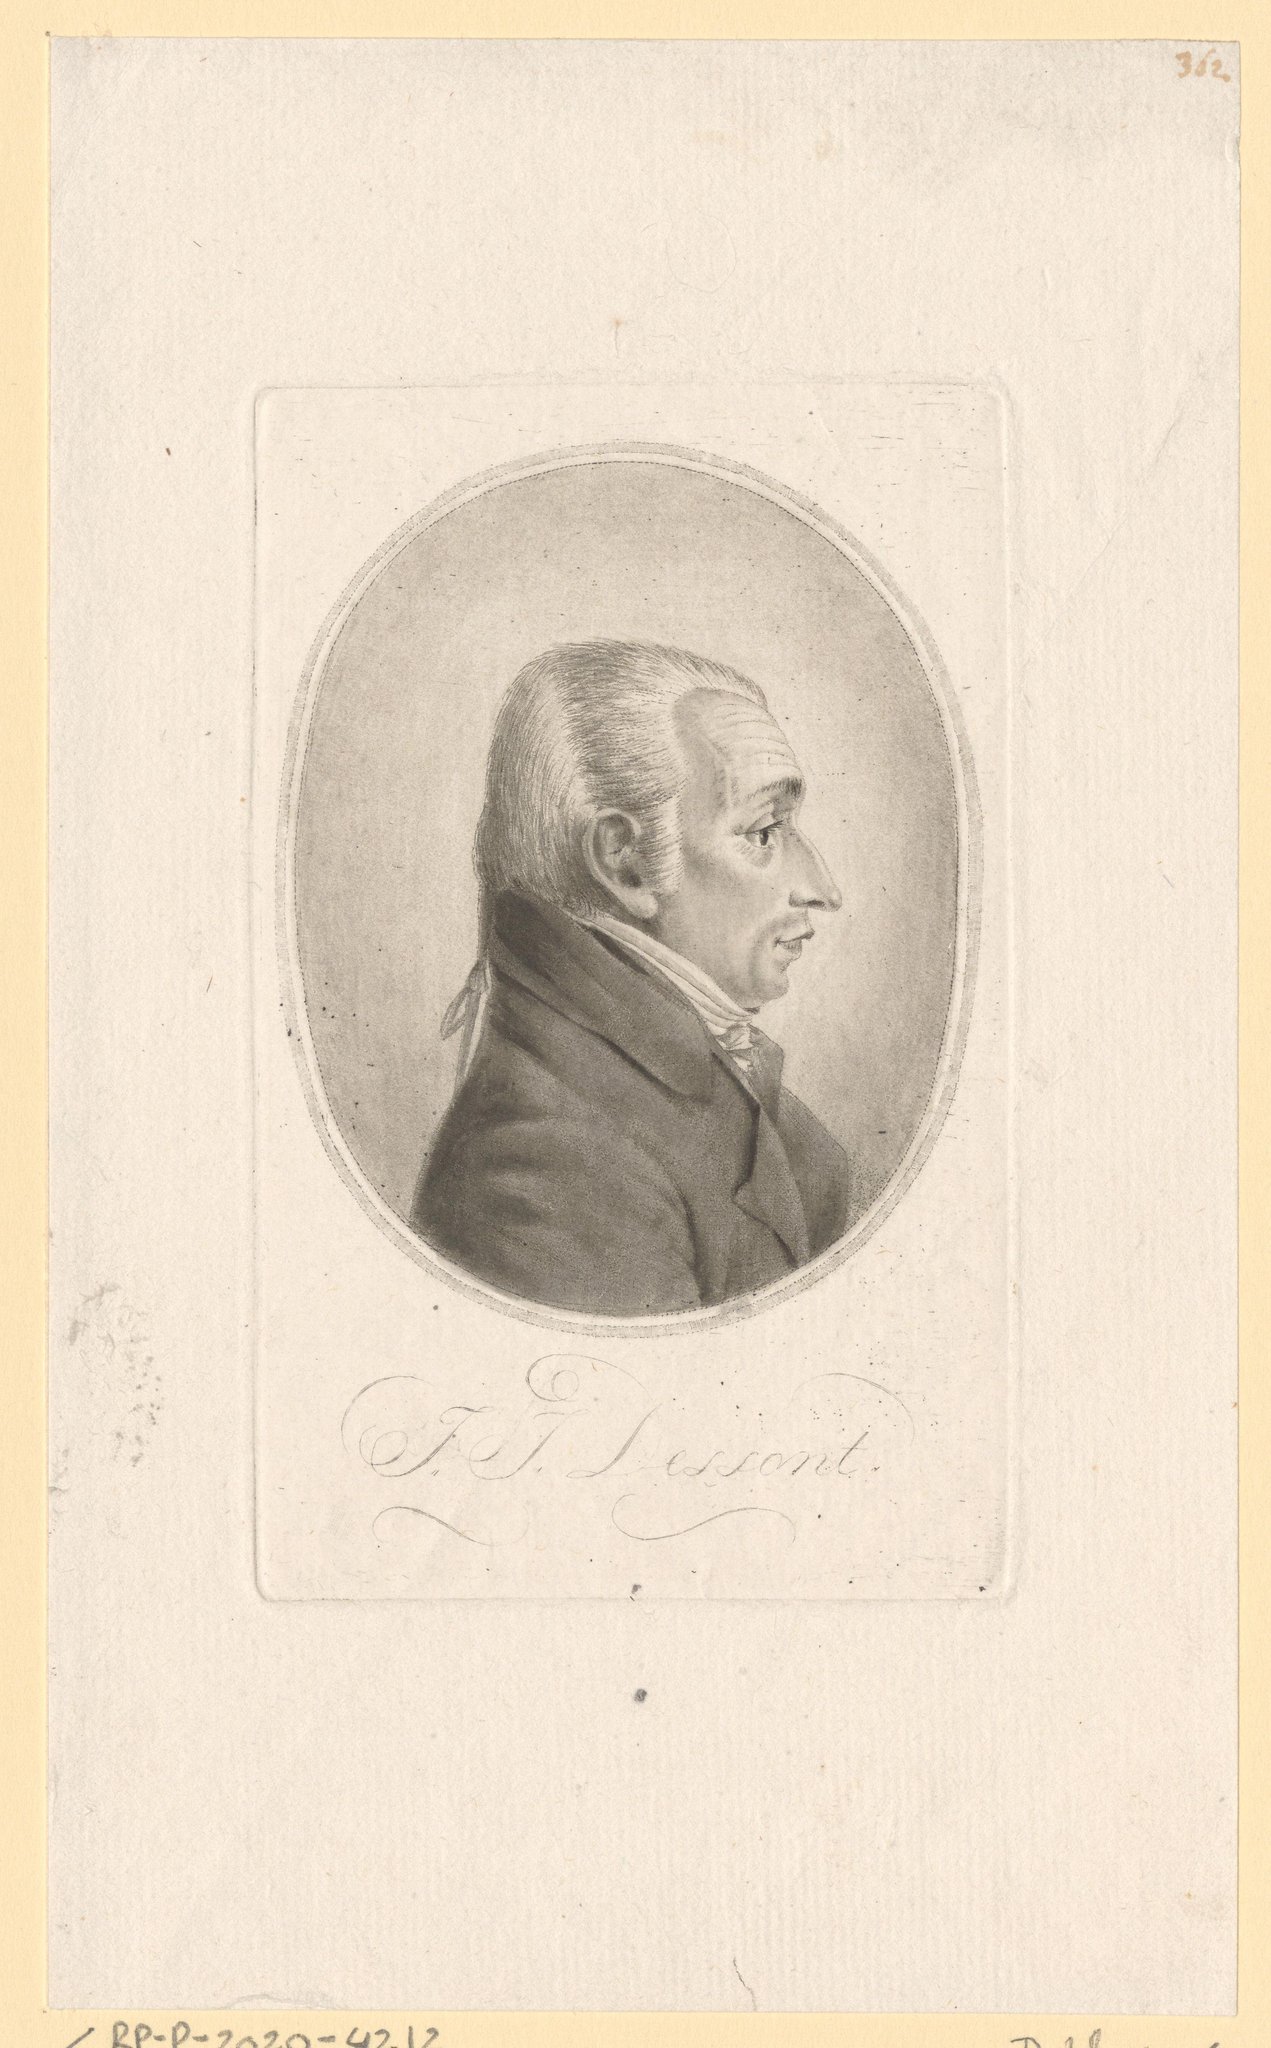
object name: print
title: Portret van J.J. Dessont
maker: Anonymous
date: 1780-1820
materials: paper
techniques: etching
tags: historical persons